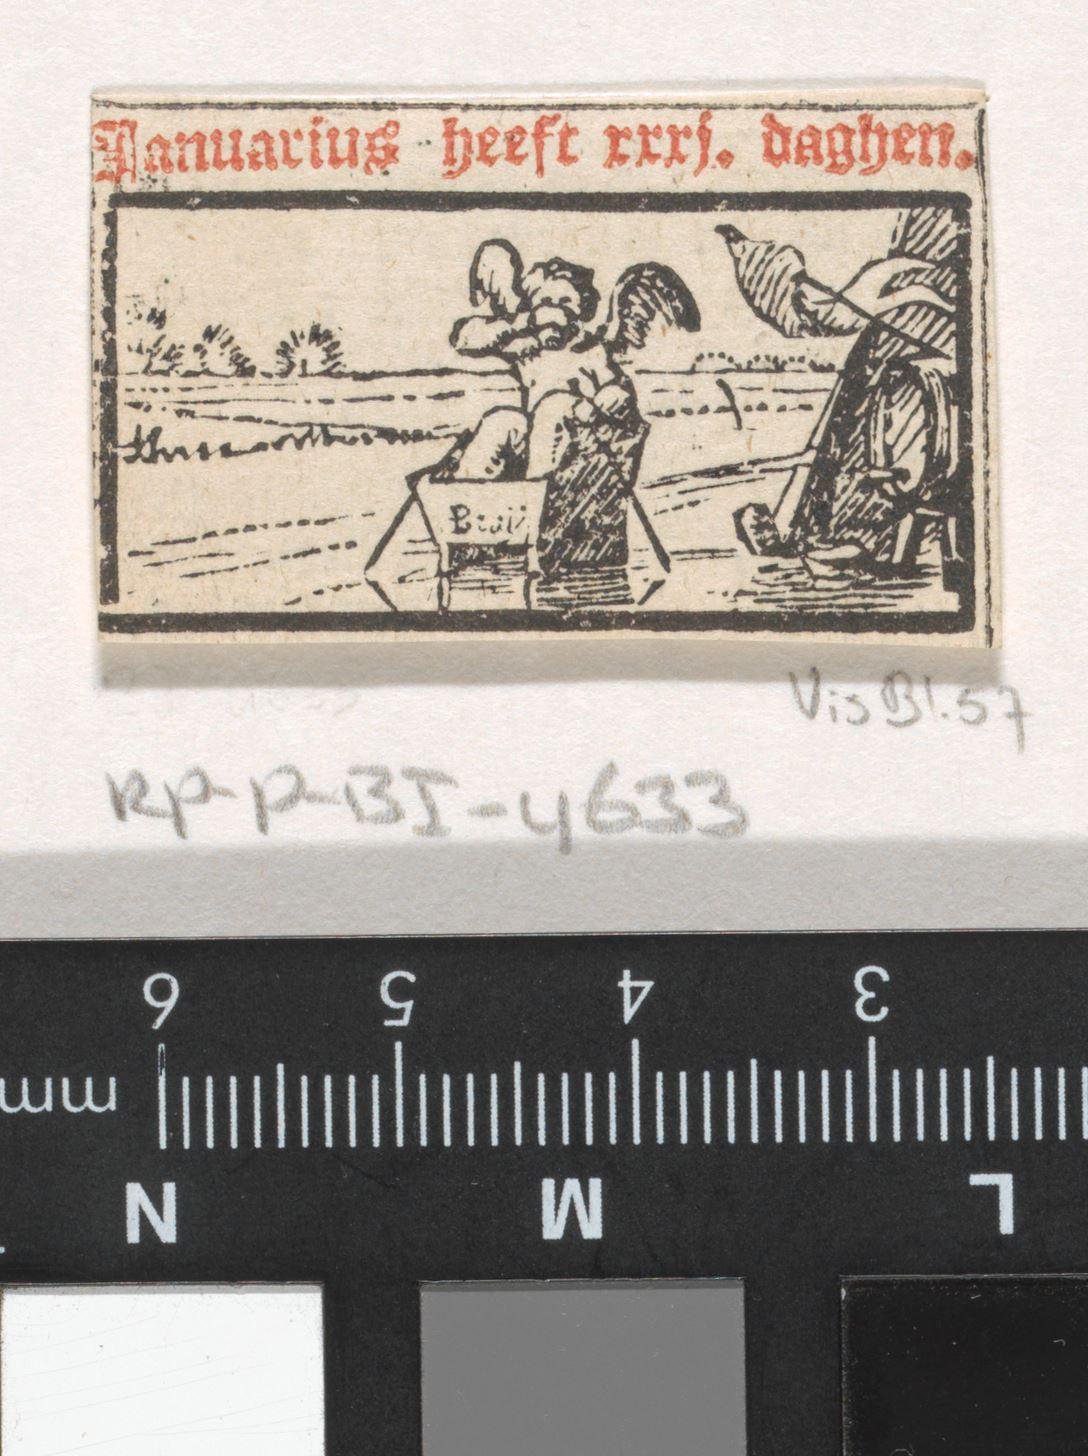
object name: print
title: Maanden van het jaar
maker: dirck de bray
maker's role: draughtsman, painter, print maker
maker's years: 1625-1694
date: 1635-1694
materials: paper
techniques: letterpress printing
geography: netherlands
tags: january and its 'labours' (+ with aquarius (january))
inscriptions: collector's mark: Lugt 2228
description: Een putto zit in een slee op het ijs. In de bovenmarge een regel Nederlandse tekst.